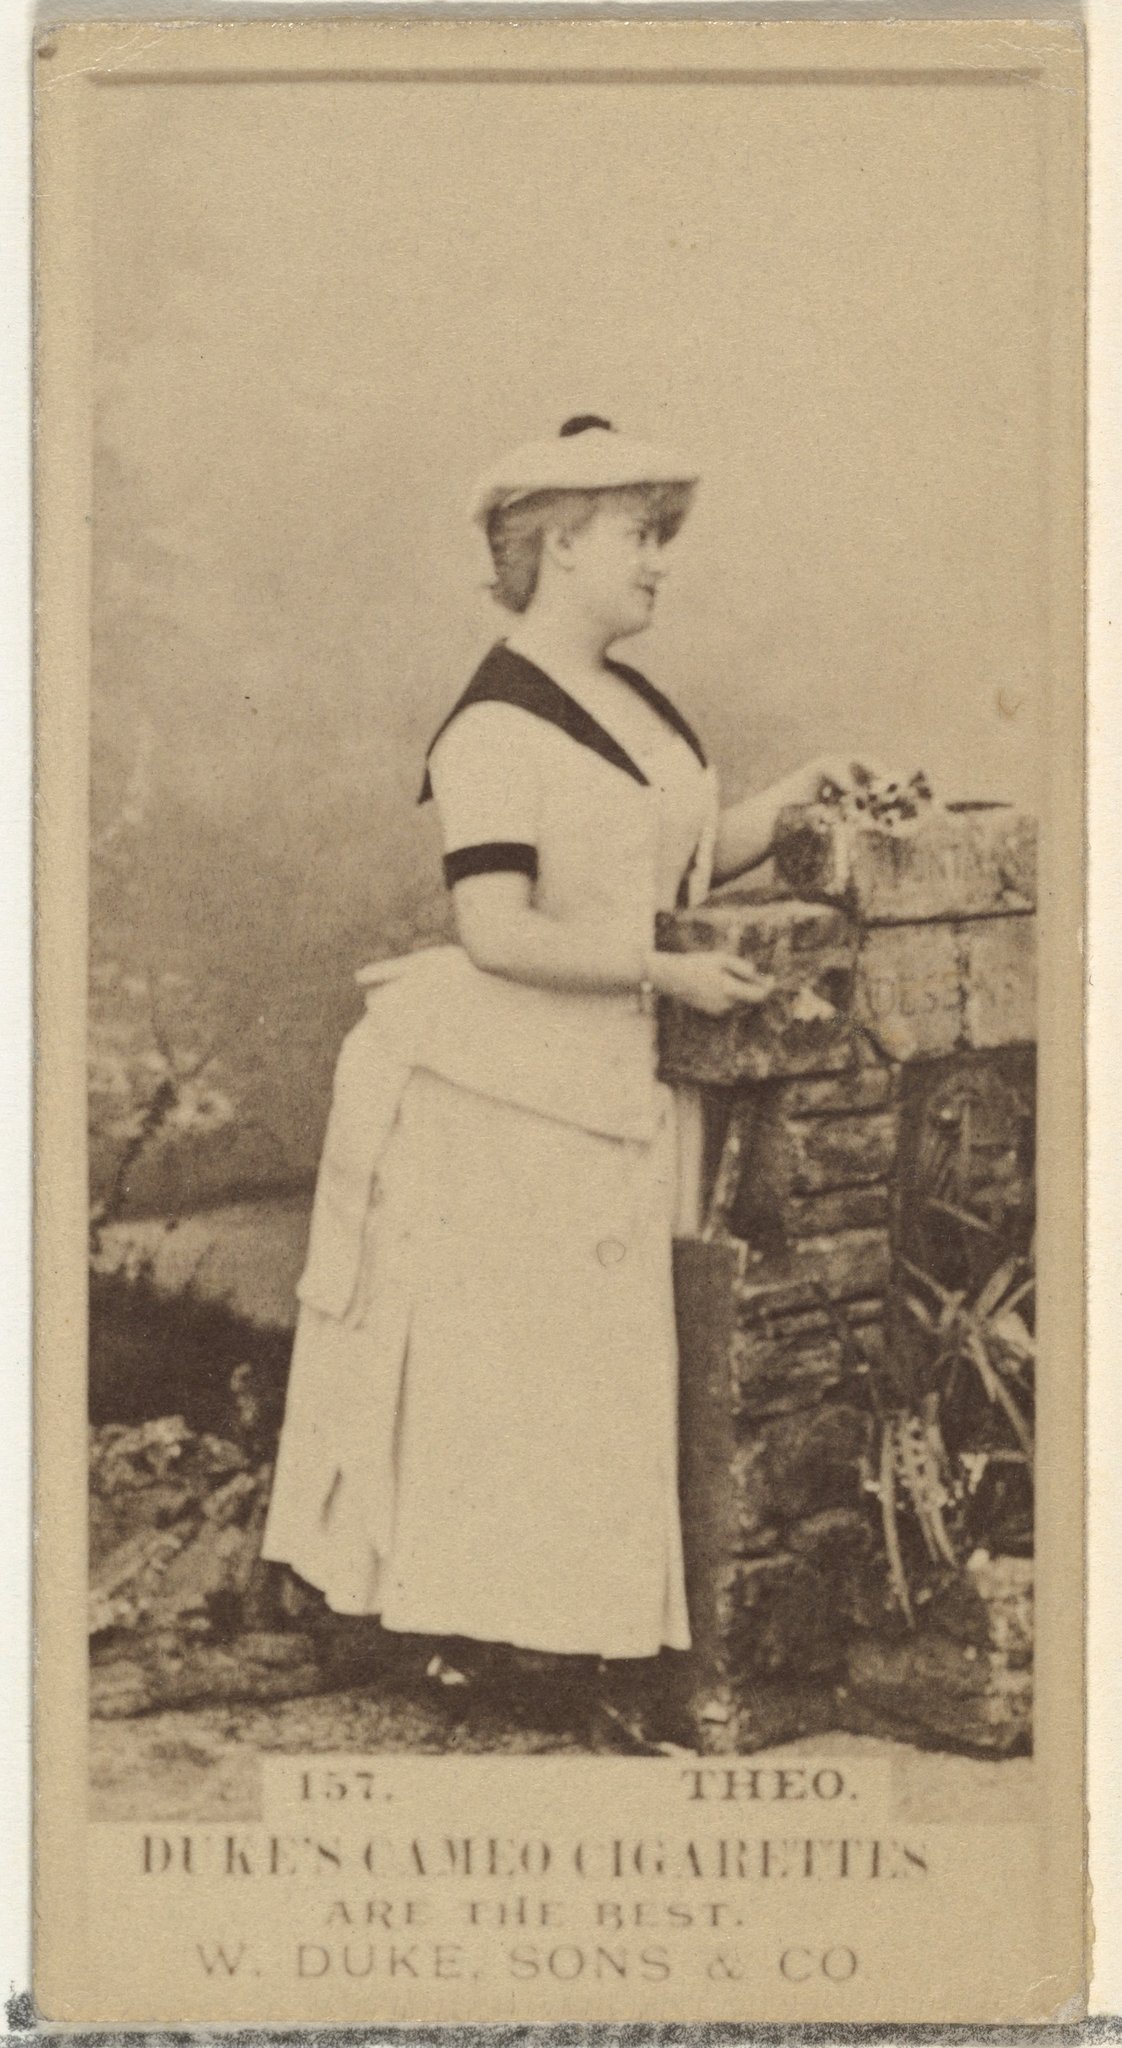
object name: photograph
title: Card Number 157, Theo, from the Actors and Actresses series (N145-5) issued by Duke Sons & Co. to promote Cameo Cigarettes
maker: w. duke, sons & co.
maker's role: publisher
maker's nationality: american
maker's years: 1870-1920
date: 1880-1889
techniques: albumen silver print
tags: women,actresses